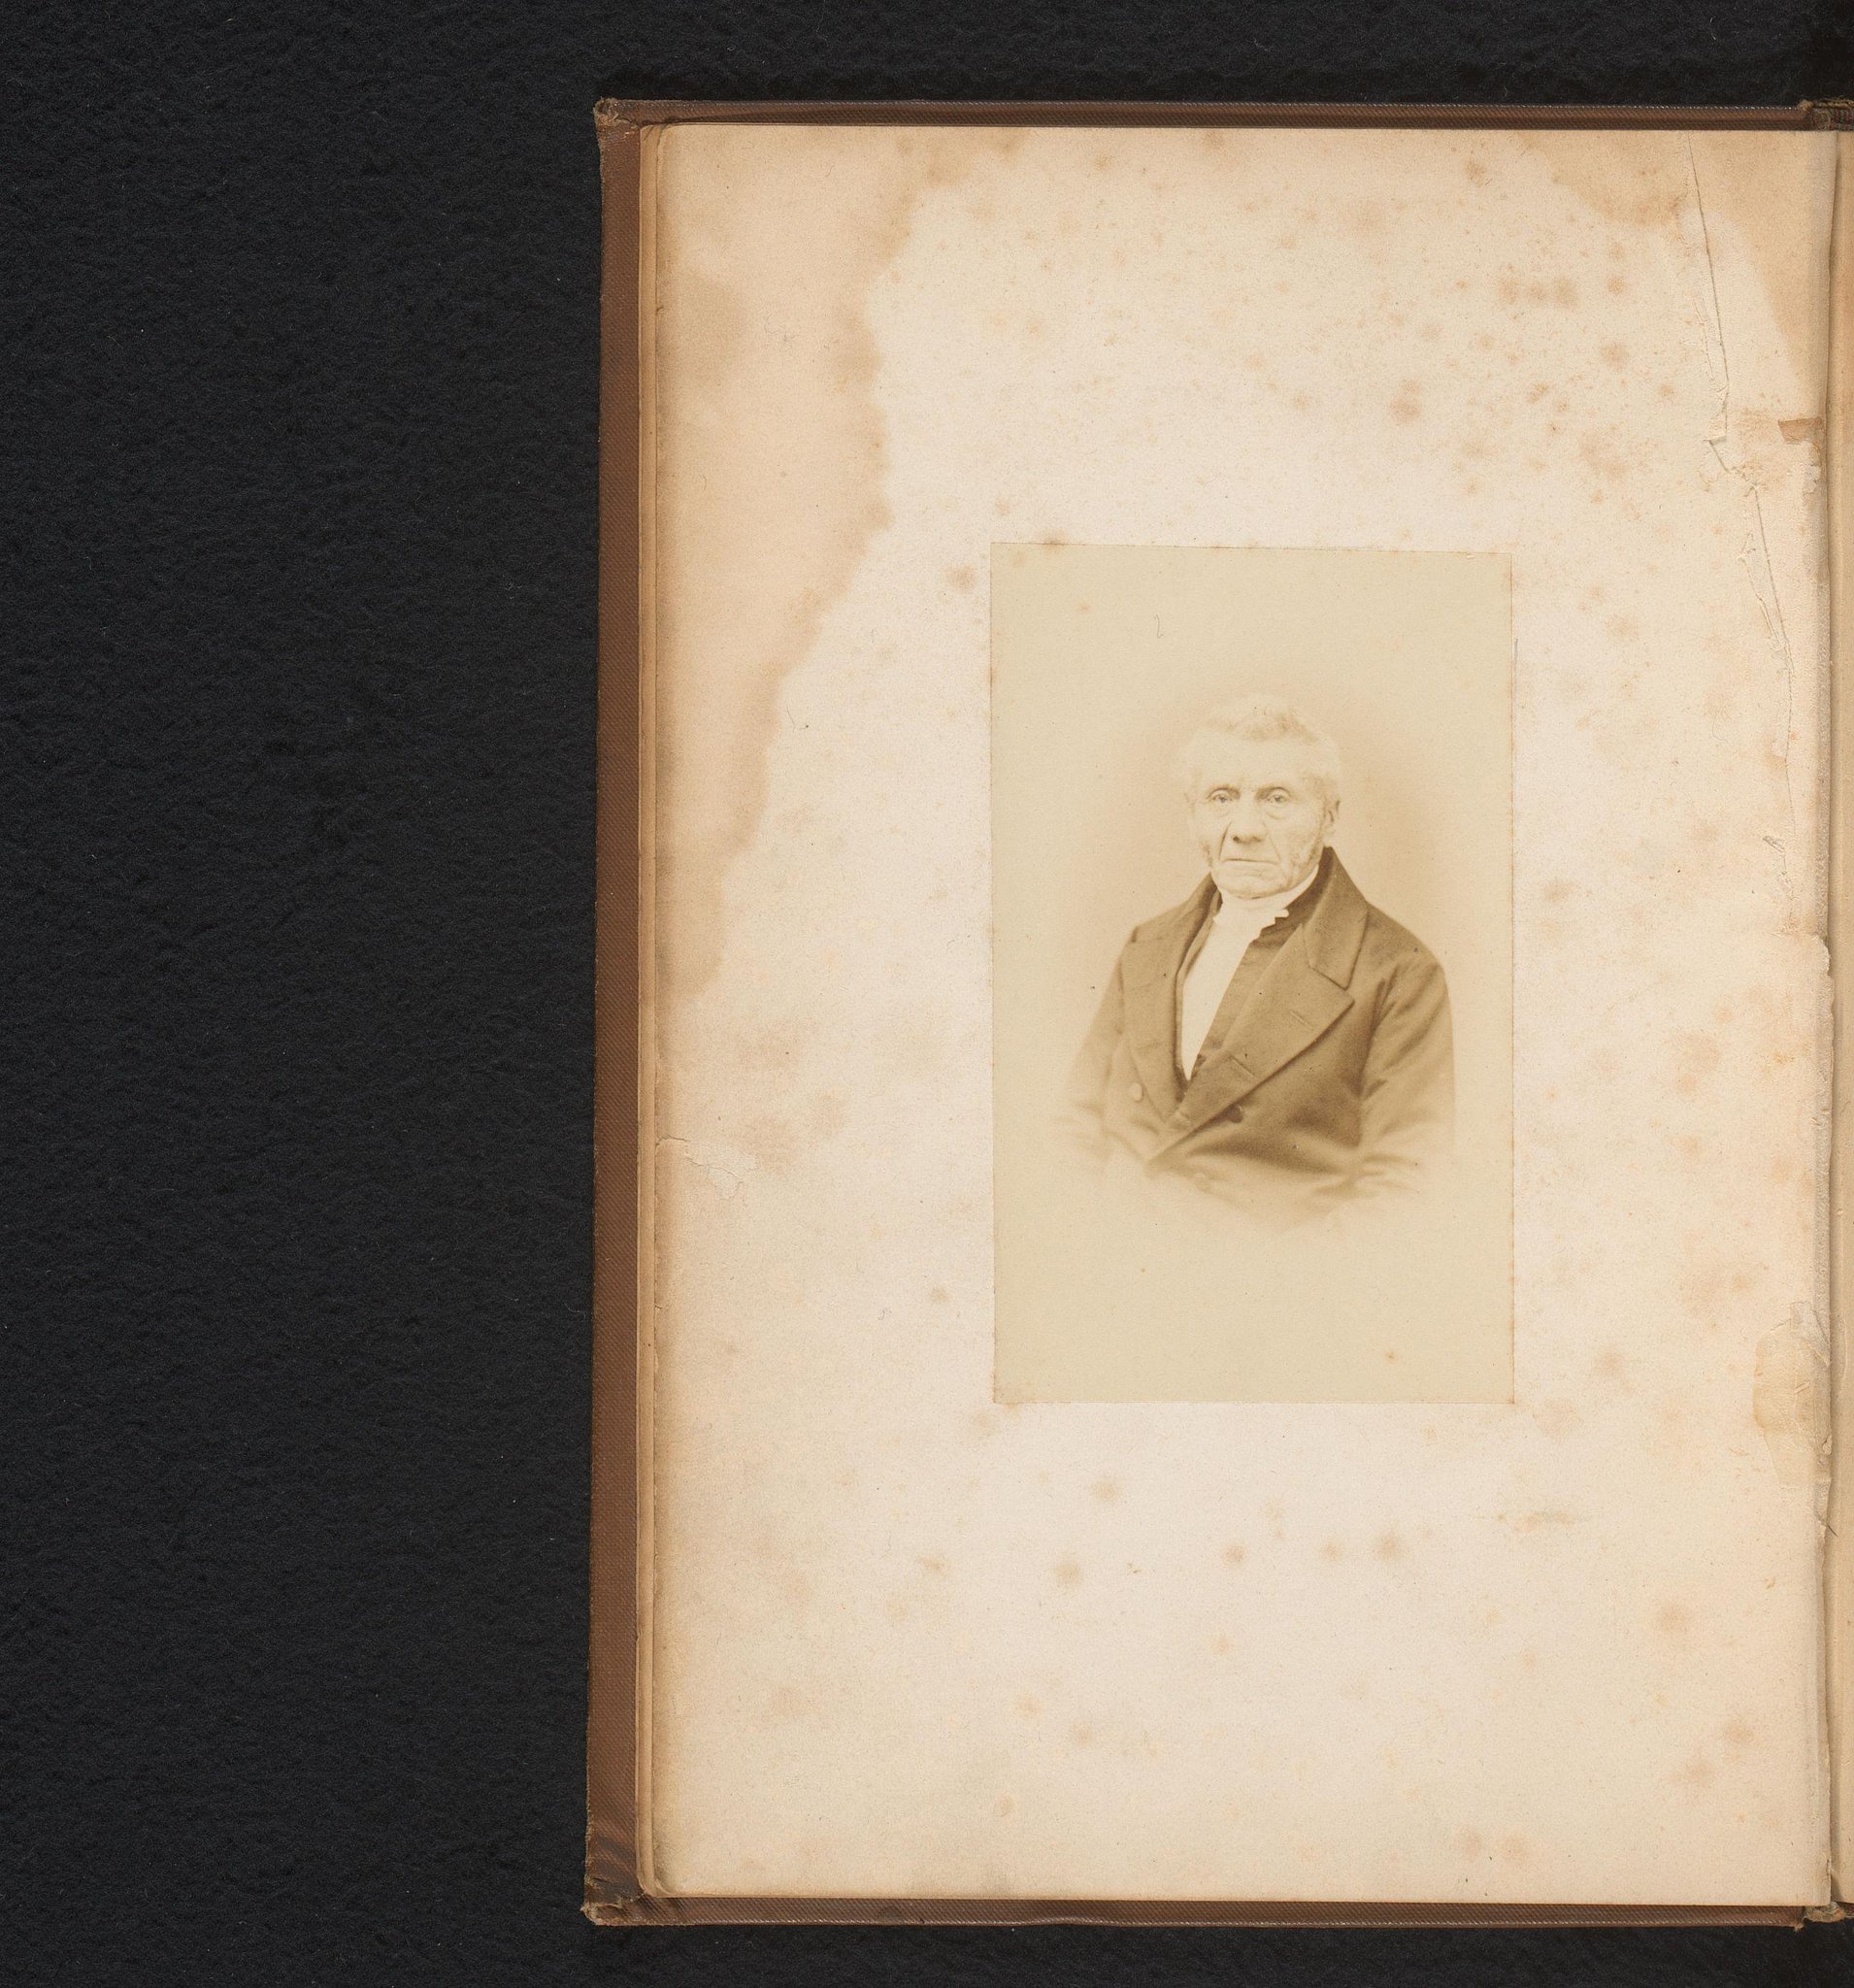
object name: photograph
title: Portret van de schrijver Franz Hoffmann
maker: Anonymous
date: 1860-1865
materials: paper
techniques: albumen print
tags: franz hoffmann, historical persons, portrait of a writer